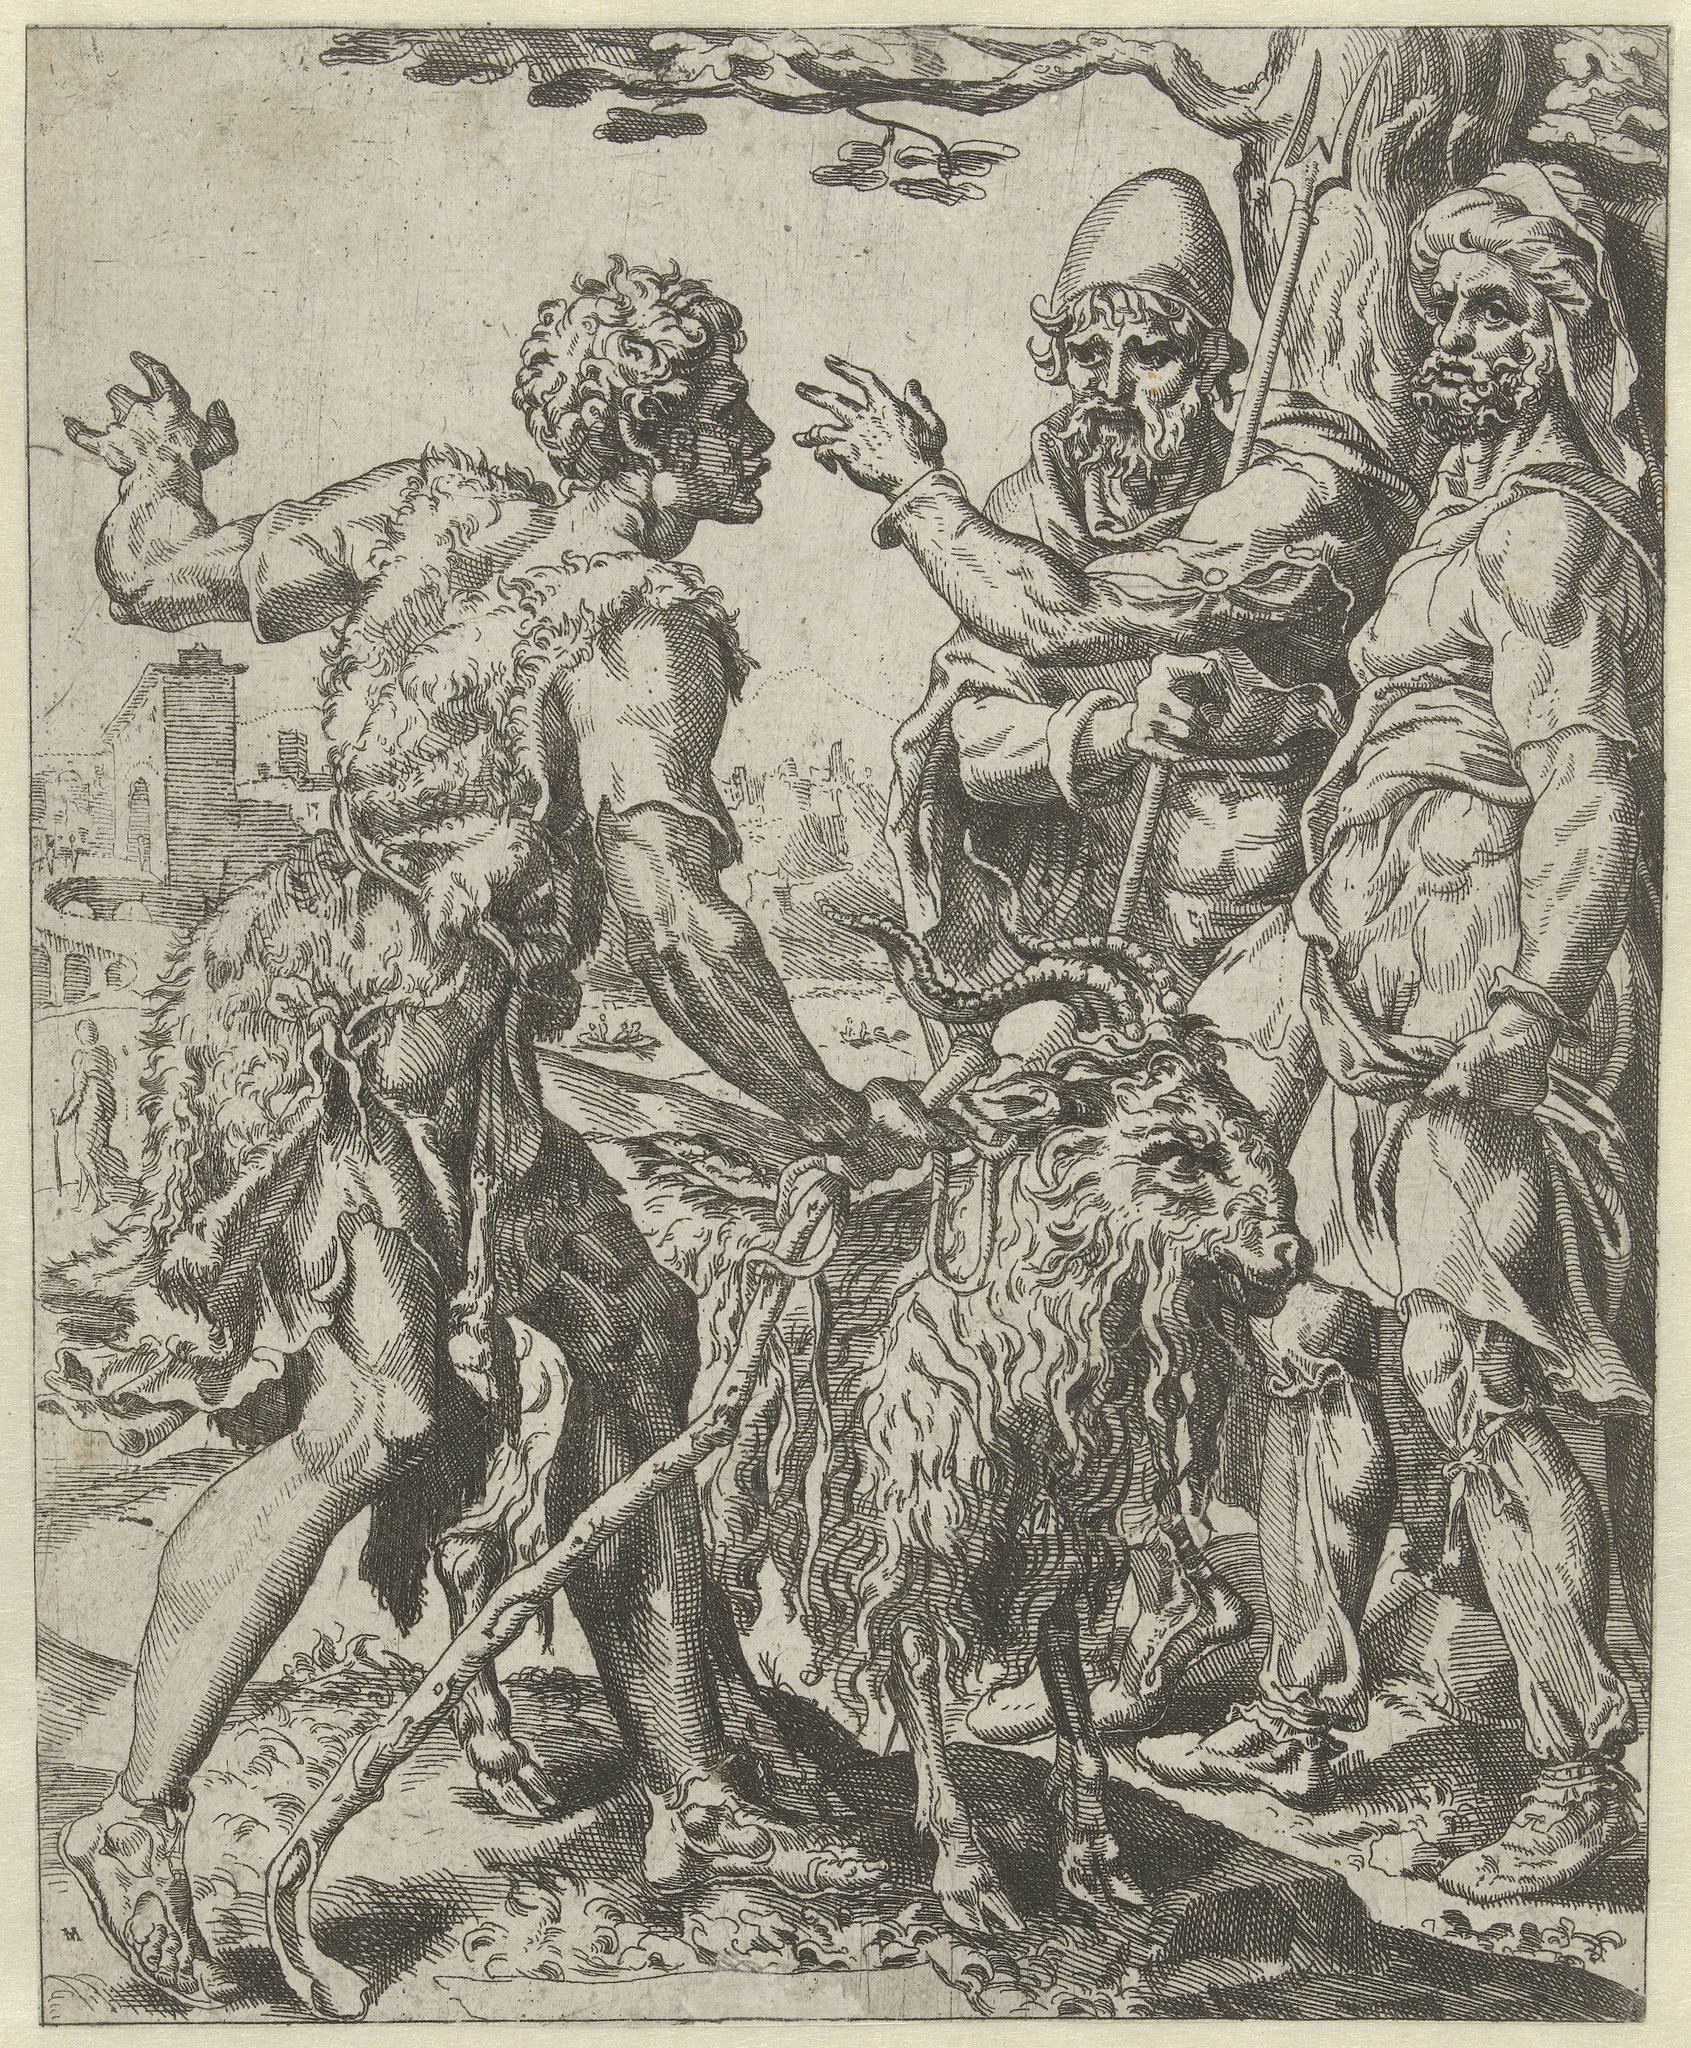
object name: print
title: Geschiedenis van Juda en Tamar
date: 1549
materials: paper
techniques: etching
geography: haarlem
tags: hirah with the promised kid of judah, looking in vain for tamar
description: Chrira zoekt naar de prostituee die zijn vriend Juda had ontmoet. Hij dient haar een geiteboek te brengen. De prent maakt deel uit van een serie over de geschiedenis van Juda en Tamar